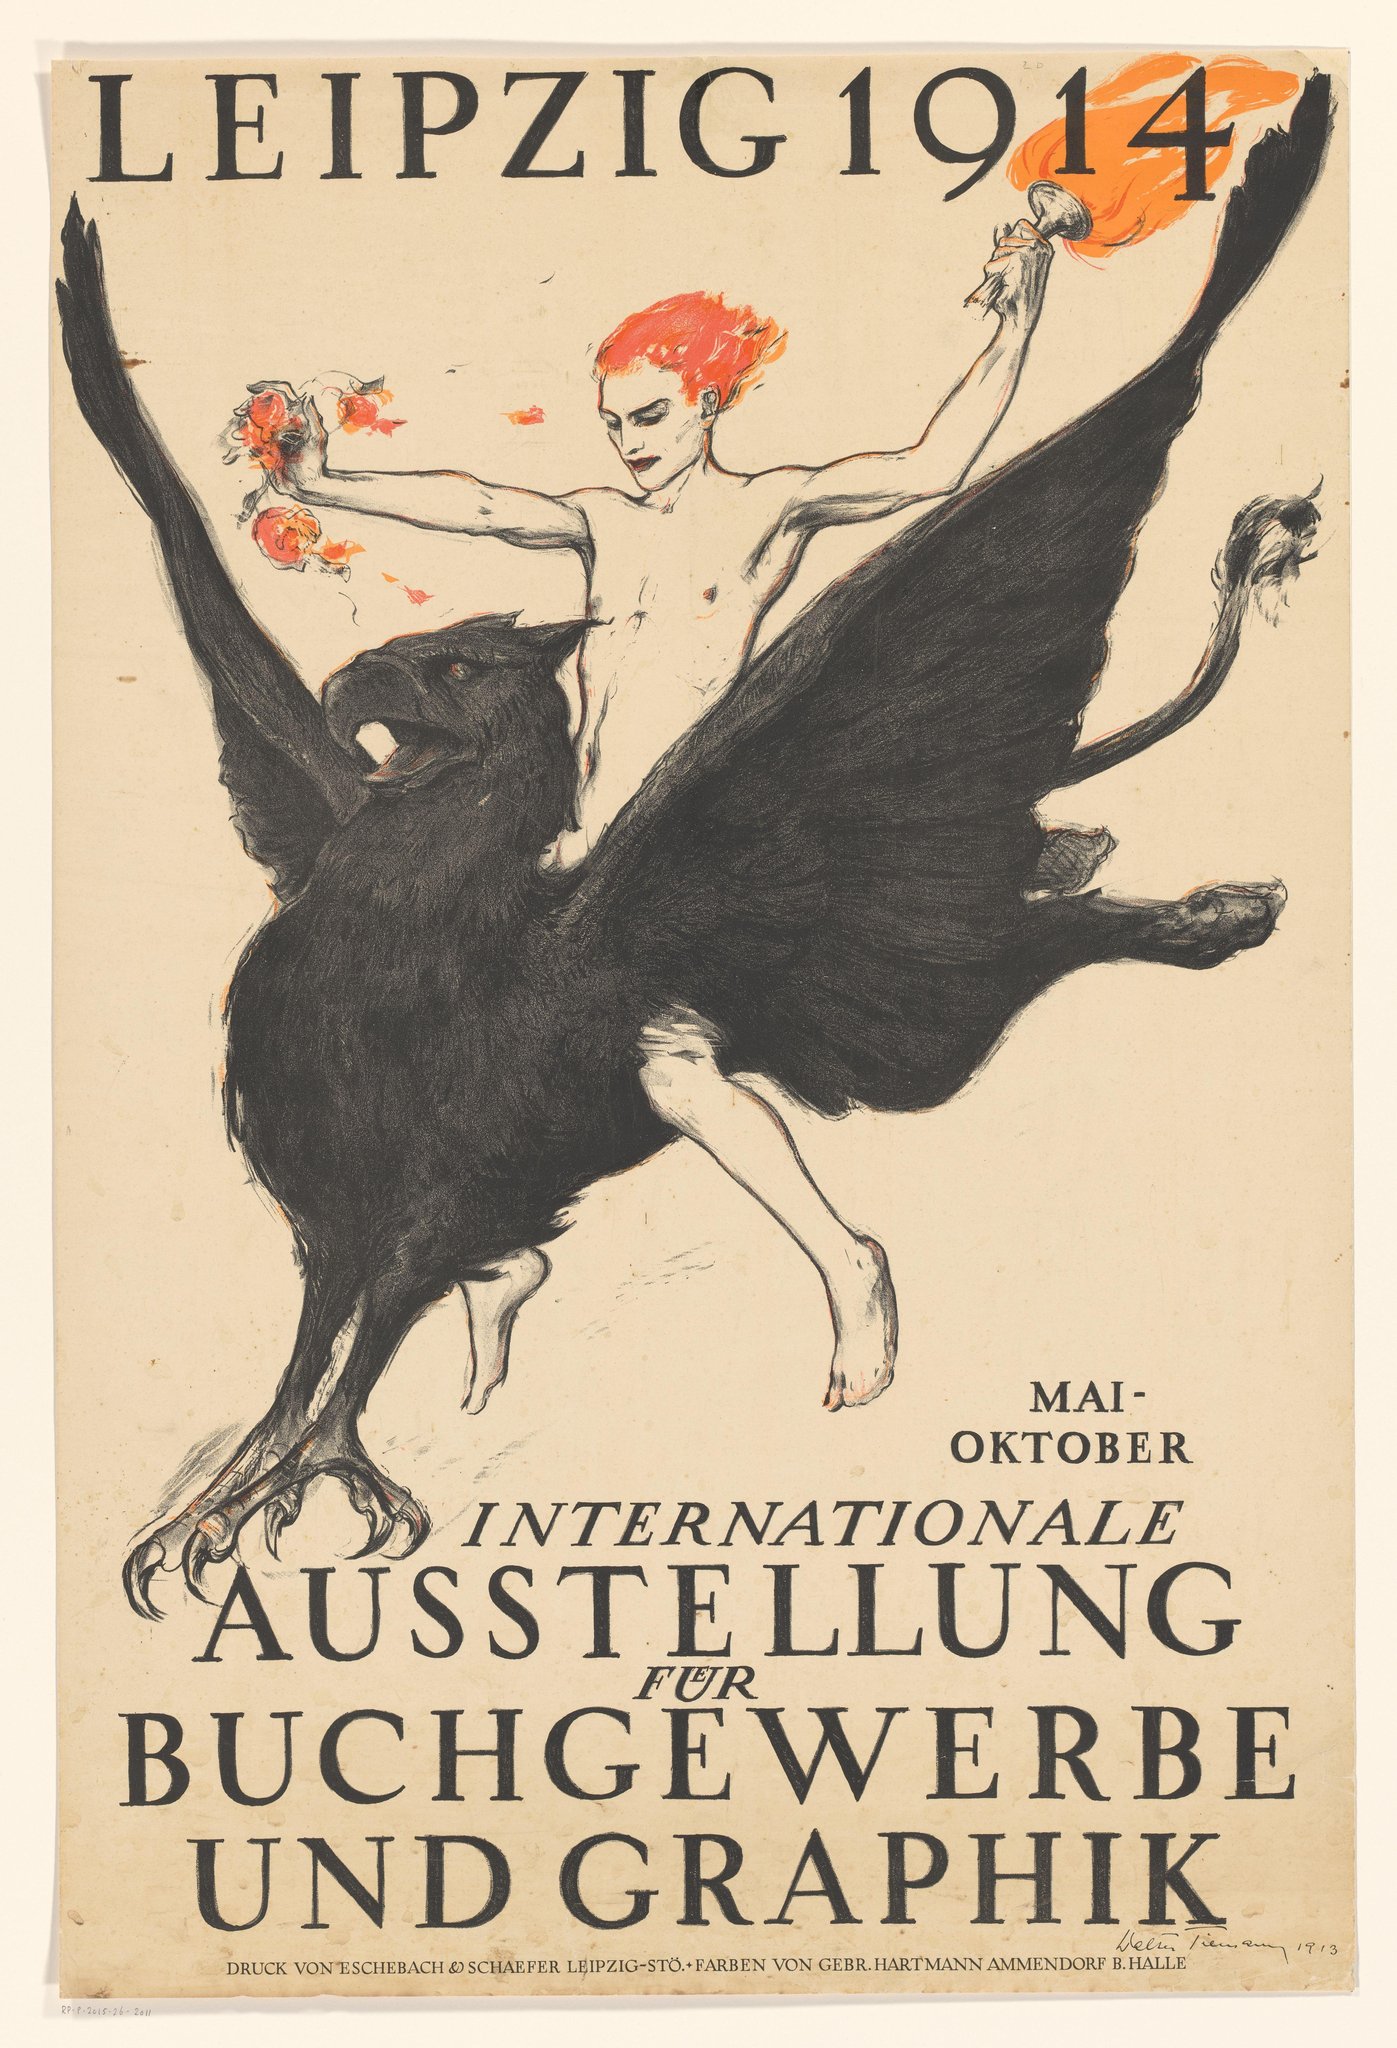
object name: print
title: Affiche voor de Internationale Tentoonstelling voor Boeknijverheid en Grafiek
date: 1913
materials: paper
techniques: lithograph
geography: leipzig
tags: griffin (lion/eagle); 'griffo' (ripa), world fair, world exhibition, 'genio' (ripa)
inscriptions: collector's mark: Lugt 2228, collector's mark: Lugt 4779, annotation: ‘Den Heer / chef / Purmerend’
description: Genius rijdend op een Griffioen met in zijn linkerhand een fakkel. Affiche gepubliceerd ter gelegenheid van de Internationale Ausstellung für Buchgewerbe und Graphik gehouden te Leipzig in 1914.